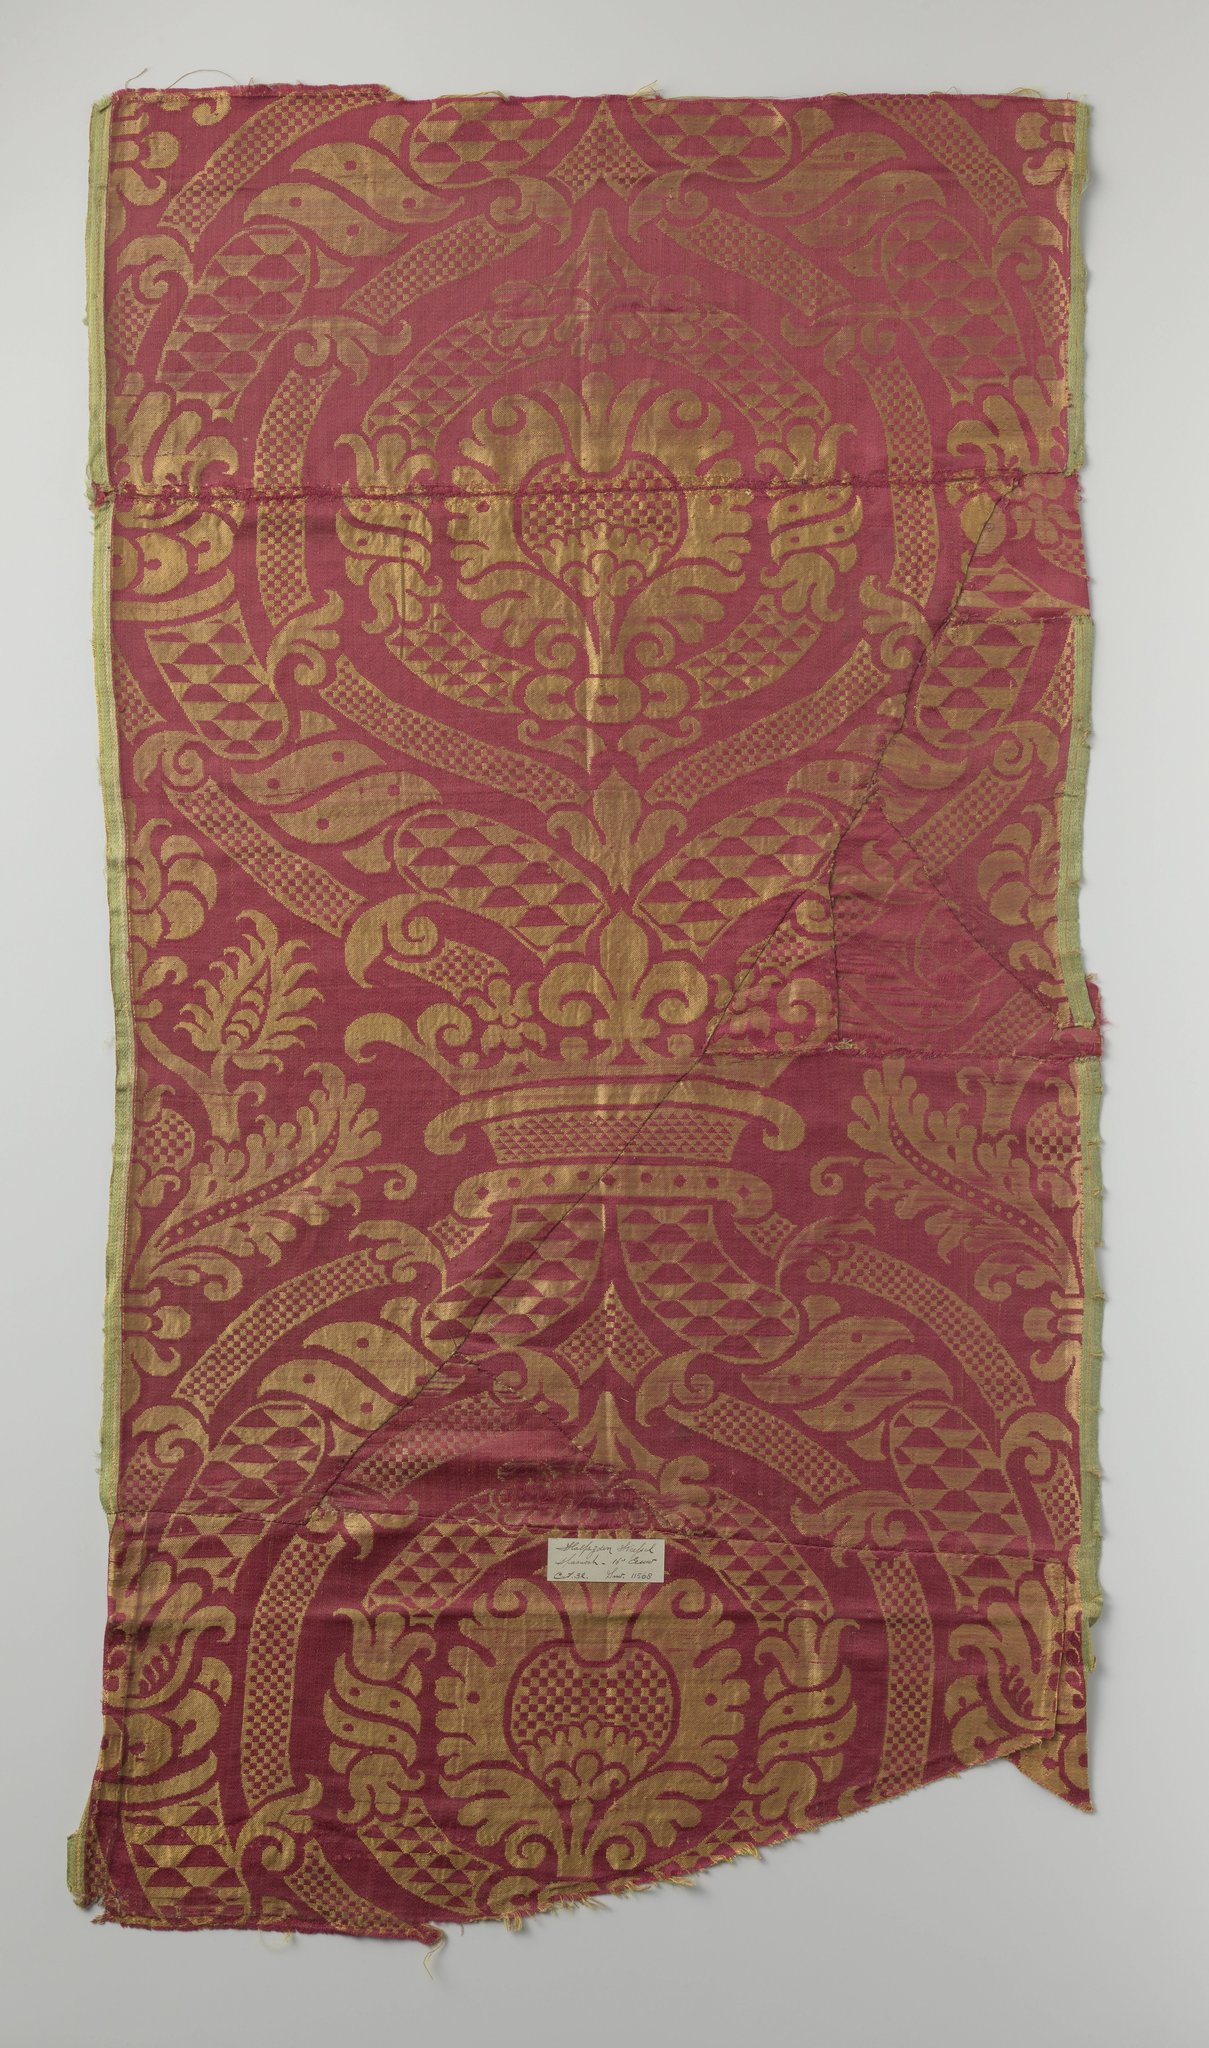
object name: zijdesatijn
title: Fragment rood met geel zijdesatijn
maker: Anonymous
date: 1550-1599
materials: silk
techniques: figure weft system, satin binding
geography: italy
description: Fragment, samengesteld uit 9 stukken, van rode zijde met patroon in geel van gekroonde medaillons met granaatappel.